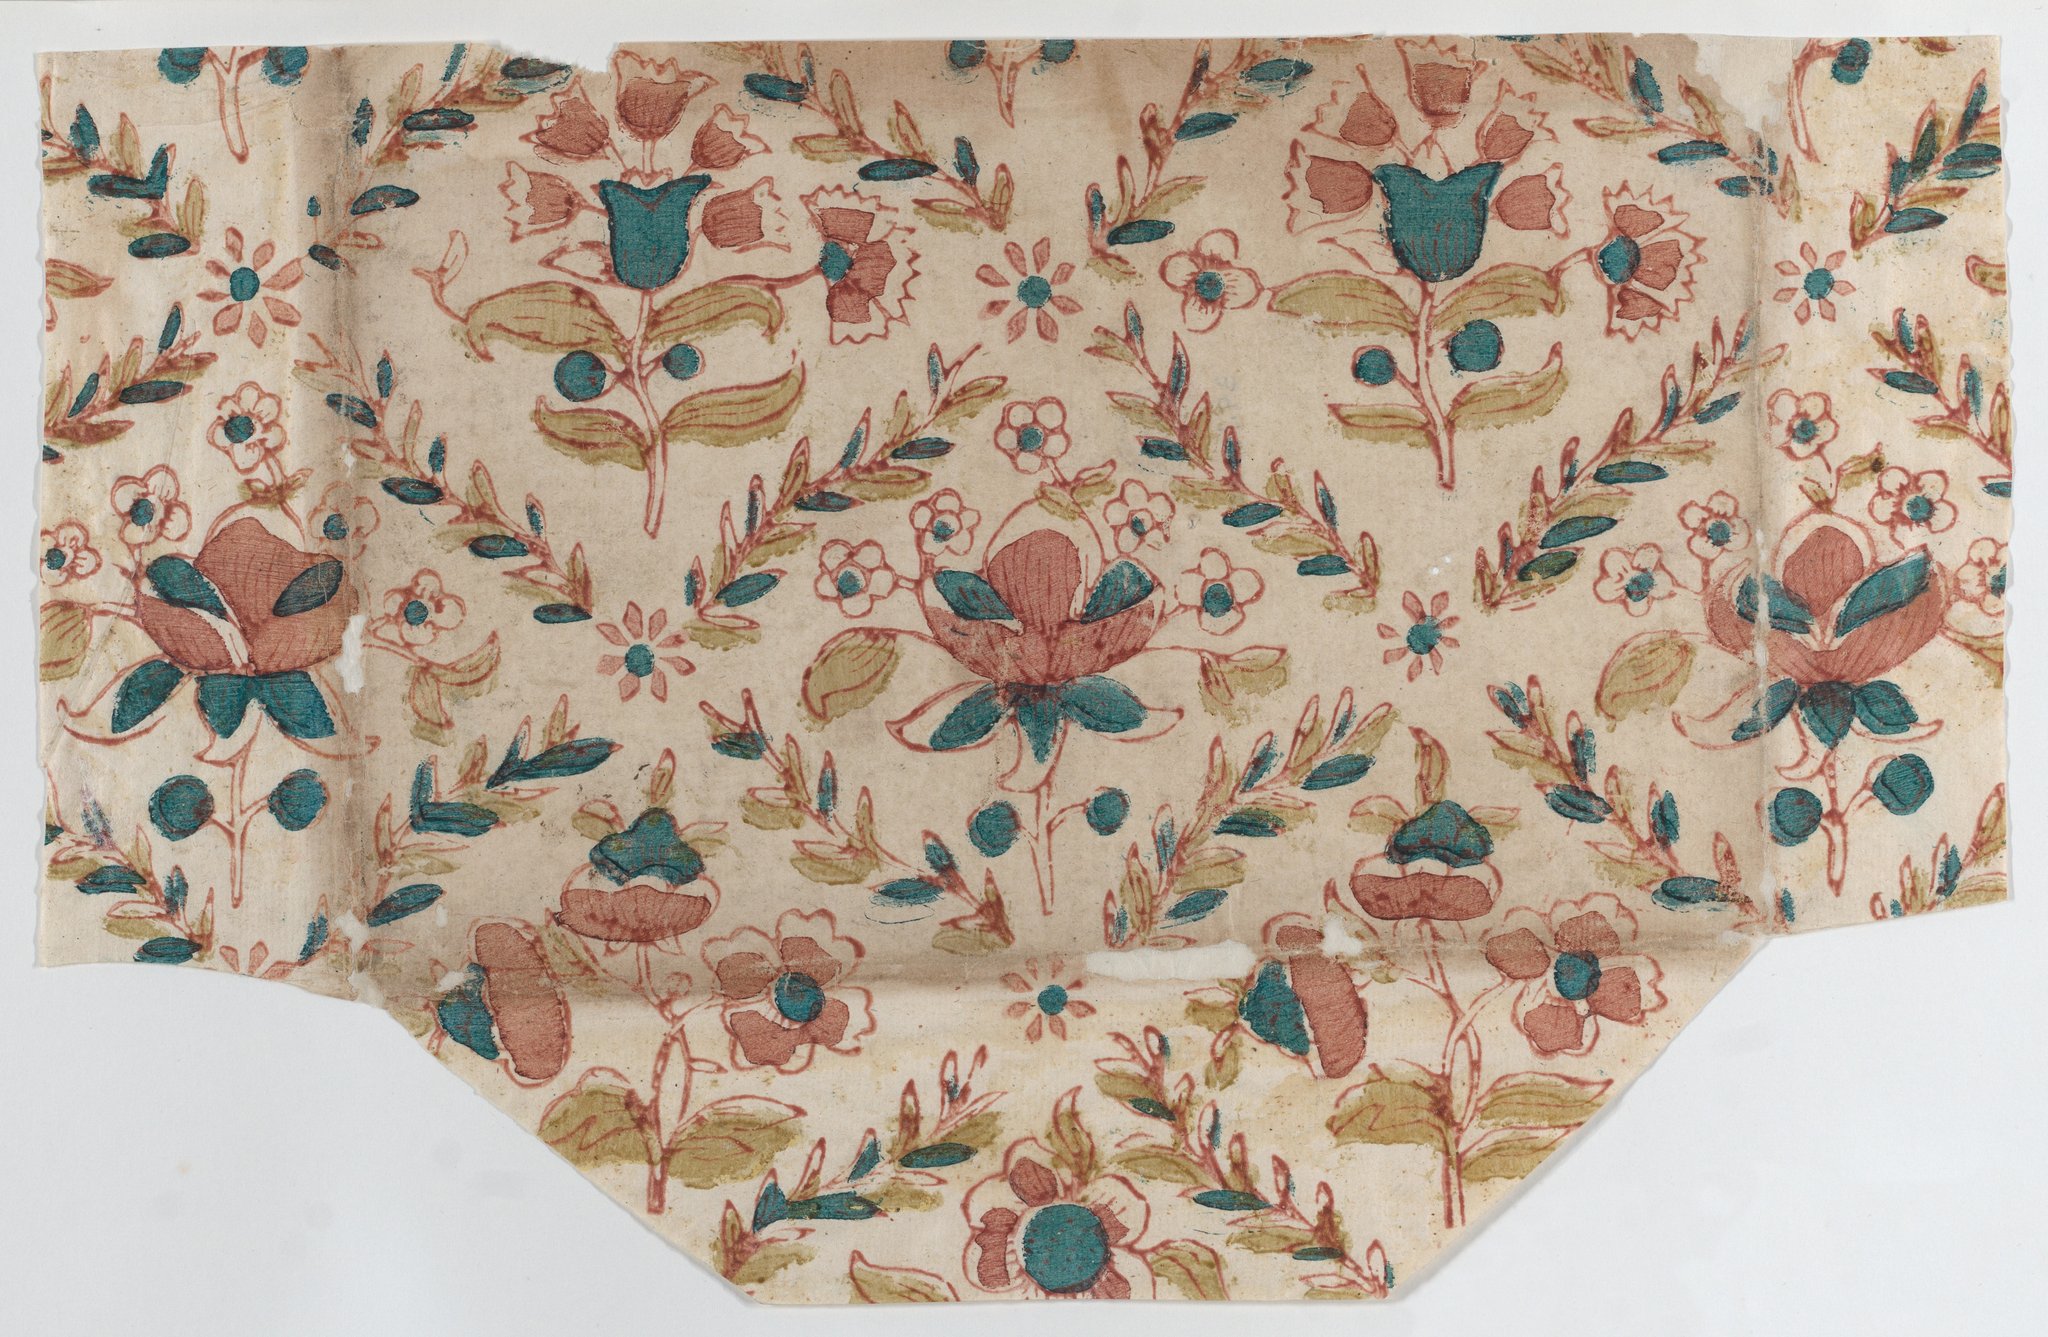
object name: print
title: Sheet with floral and leaf pattern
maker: Anonymous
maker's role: artist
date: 1701-1800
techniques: relief print